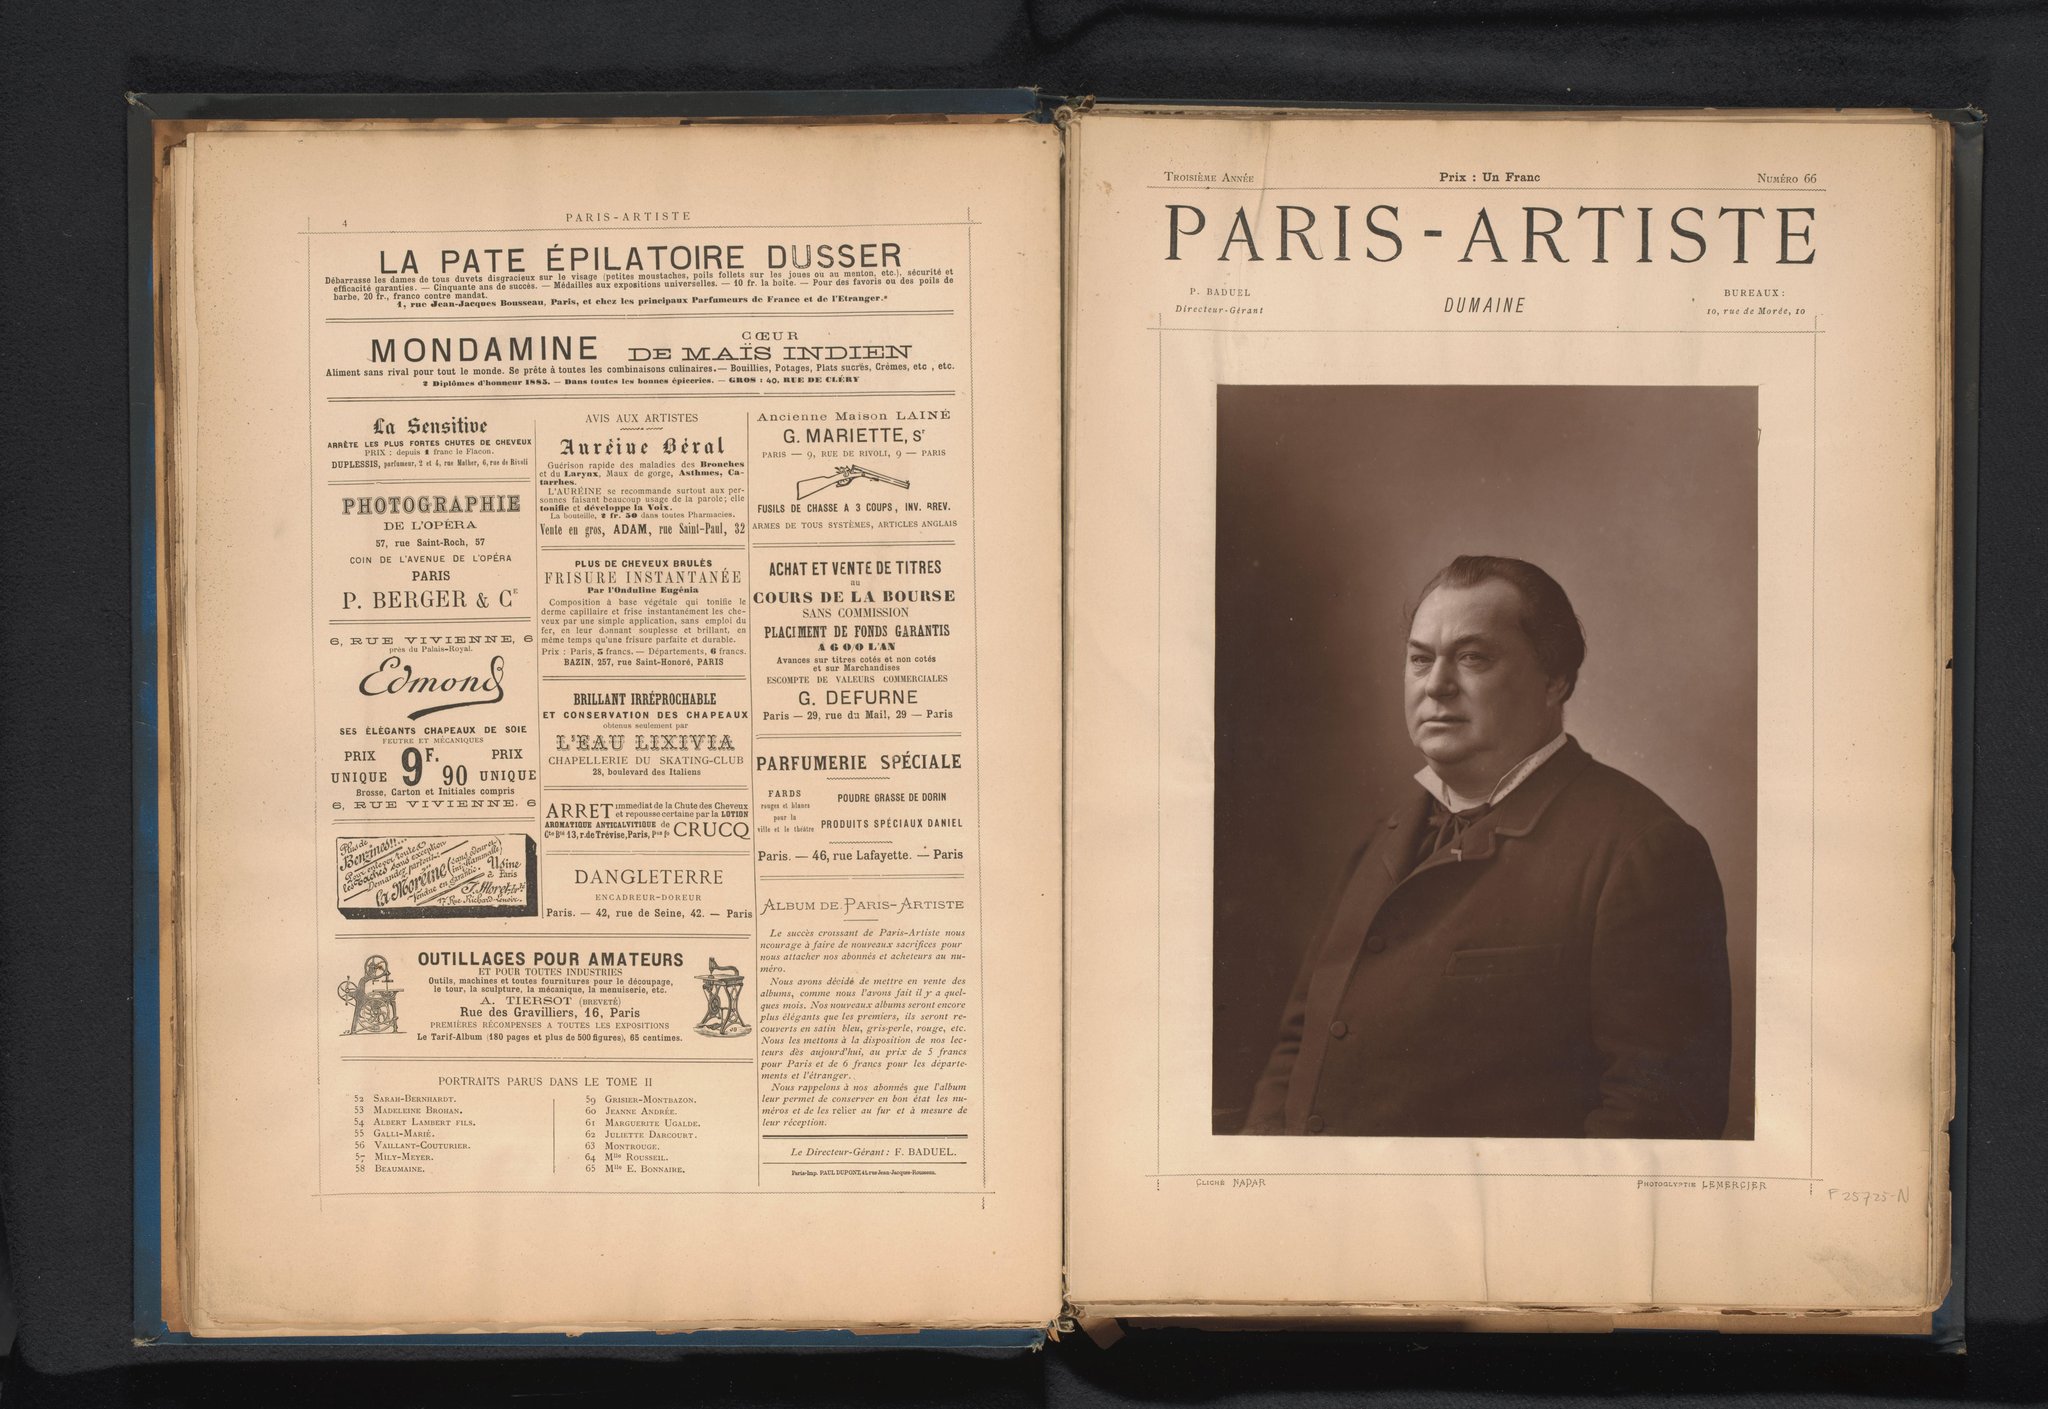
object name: page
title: Portret van Louis-François Dumaine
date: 1880-1885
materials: paper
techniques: woodburytype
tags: historical persons, portrait of actor, actress